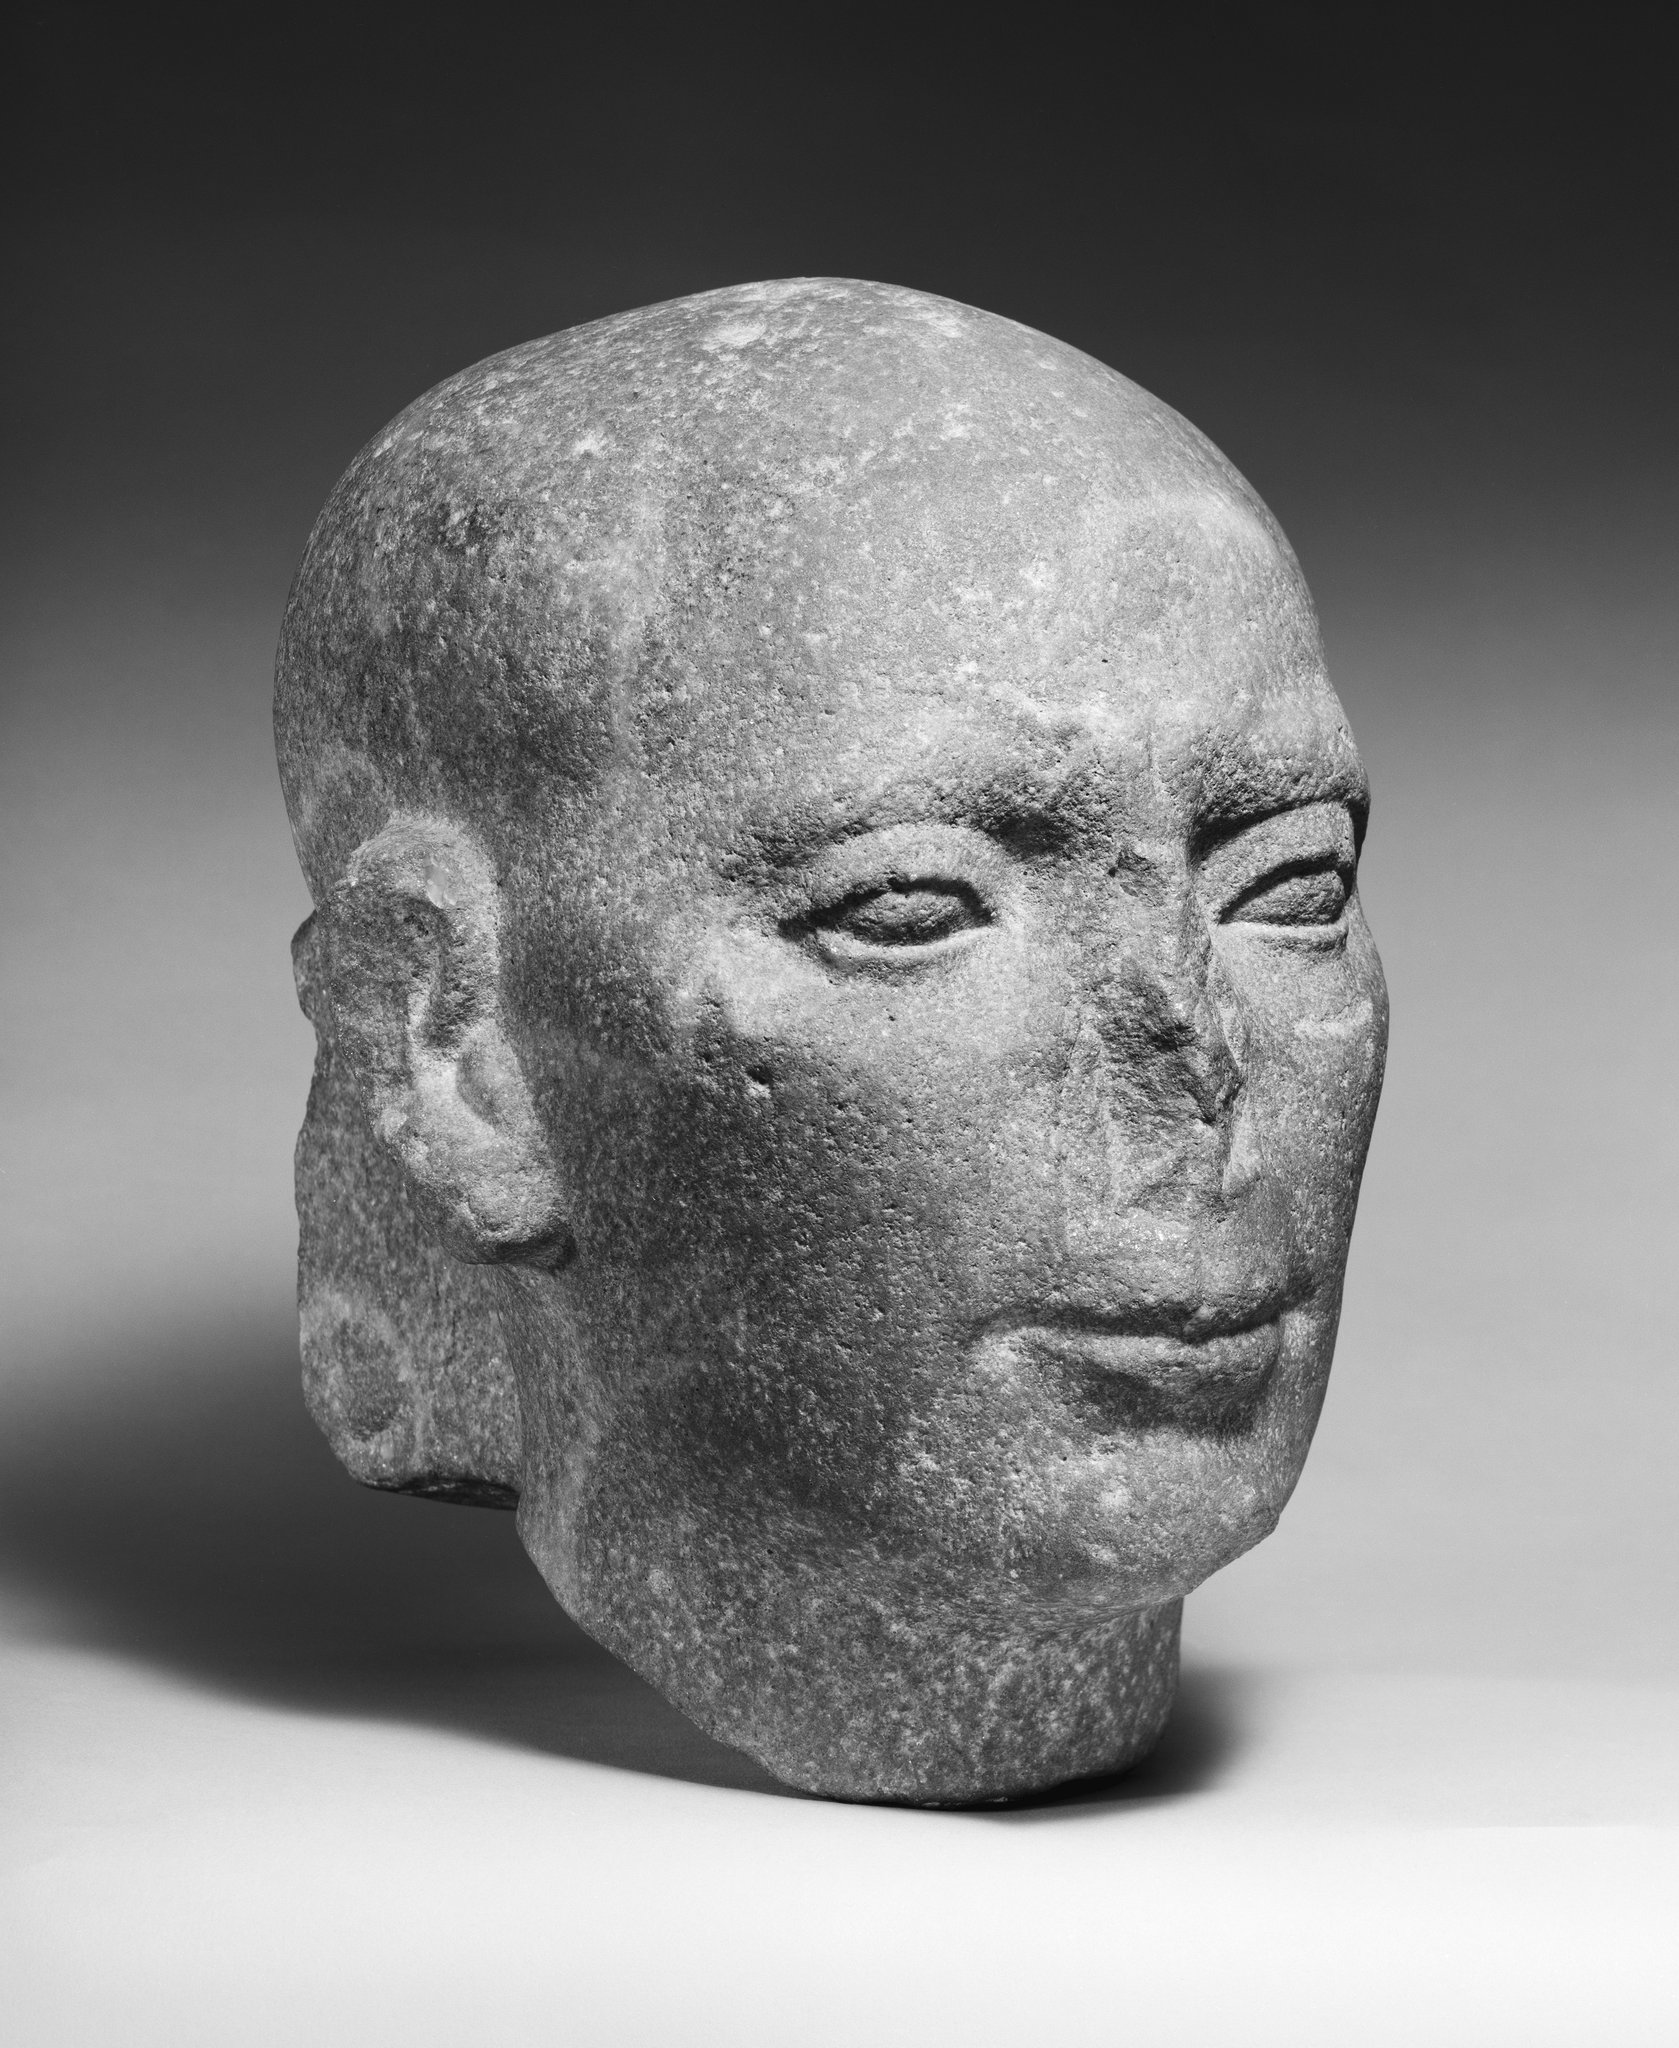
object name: head, priest or dignitary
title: Head from a Large Statue of a Priest or Dignitary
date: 1700-1600 BCE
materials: quartzite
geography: egypt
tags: heads,men